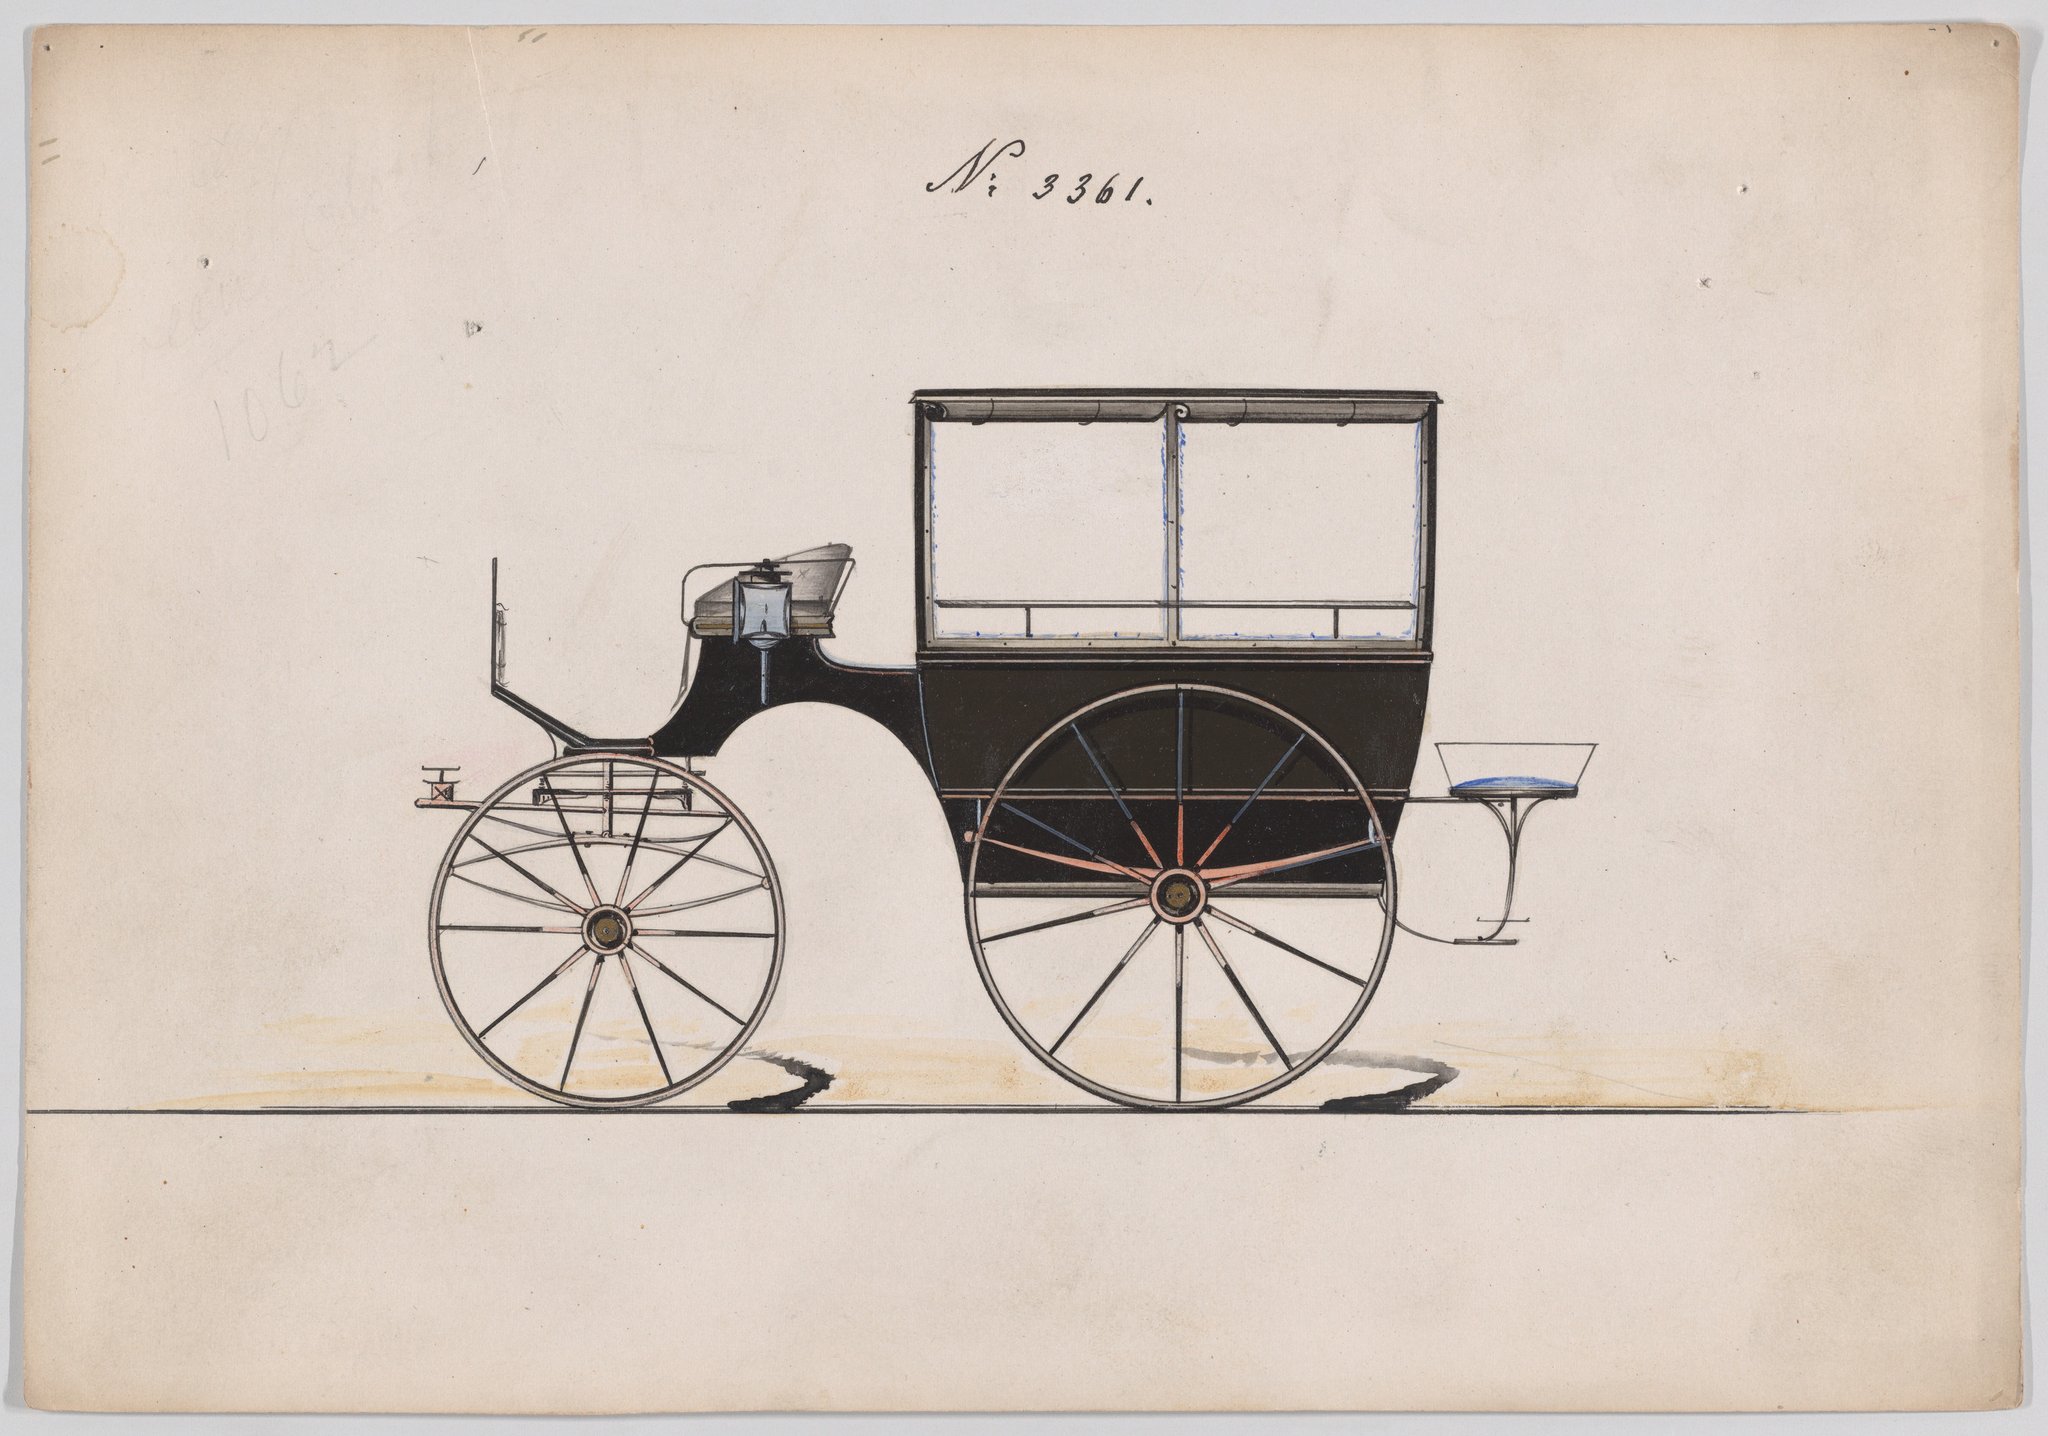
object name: drawing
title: Omnibus Wagonette #3361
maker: brewster & co.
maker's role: manufacturer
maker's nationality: american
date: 1877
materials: gouache, ink, watercolor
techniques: pen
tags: carriages